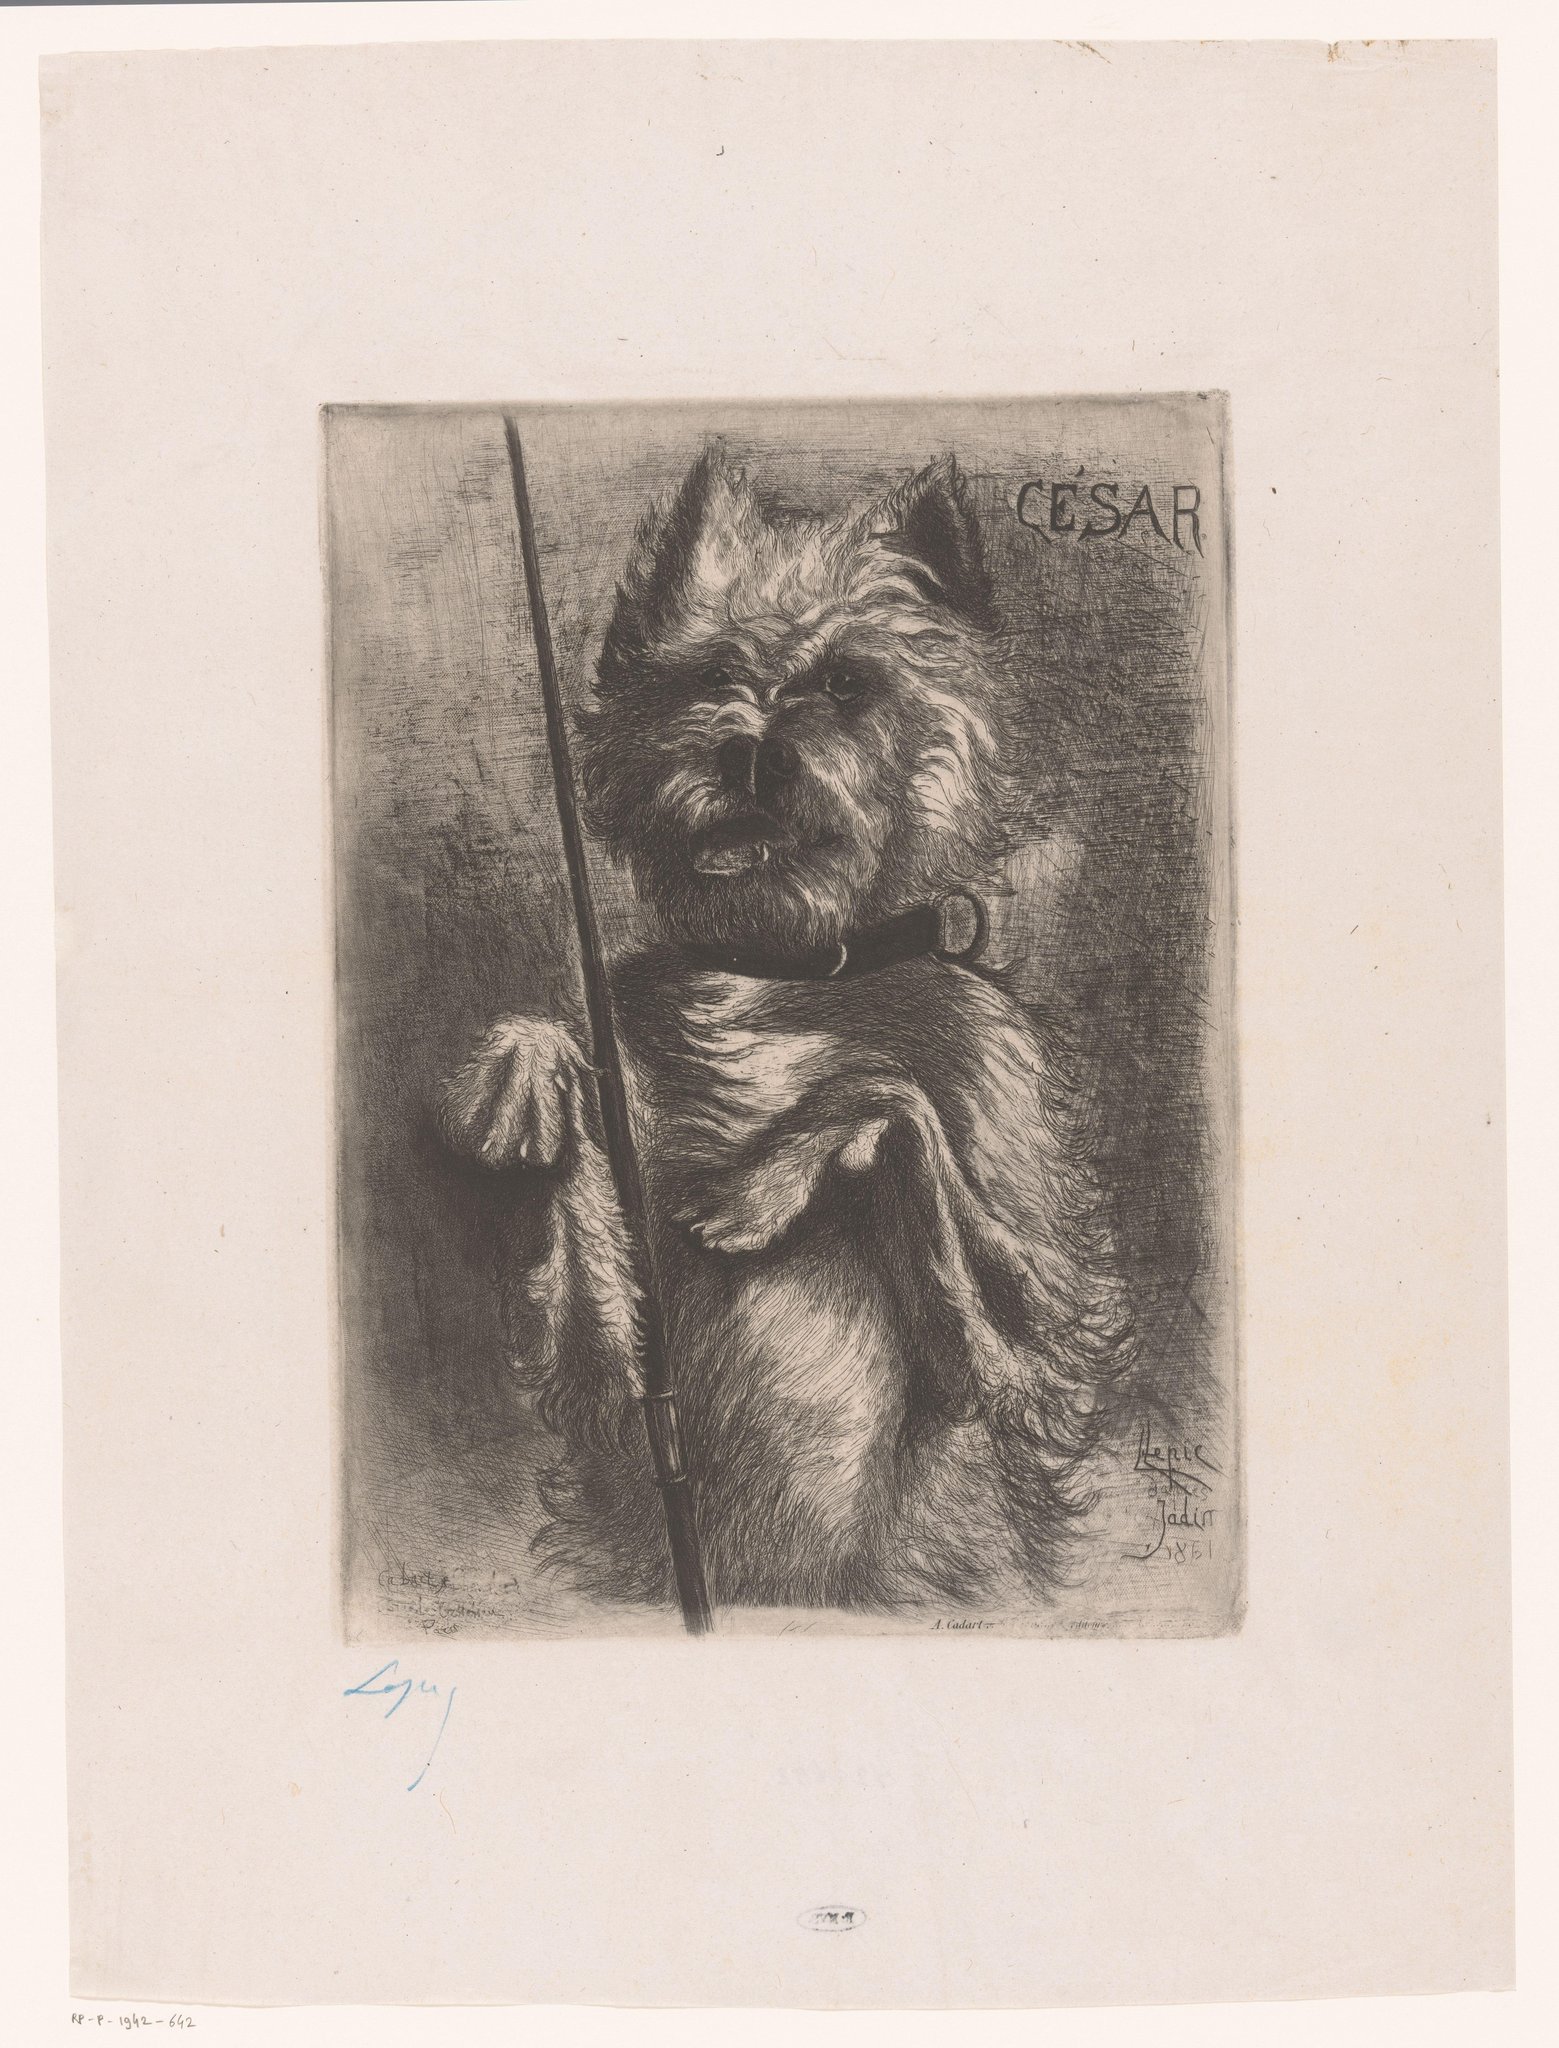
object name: print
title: Hond op achterpoten met stok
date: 1861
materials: paper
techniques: etching, intaglio, roulette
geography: paris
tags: collar (of a dog), dog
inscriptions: collector's mark: Lugt 2228